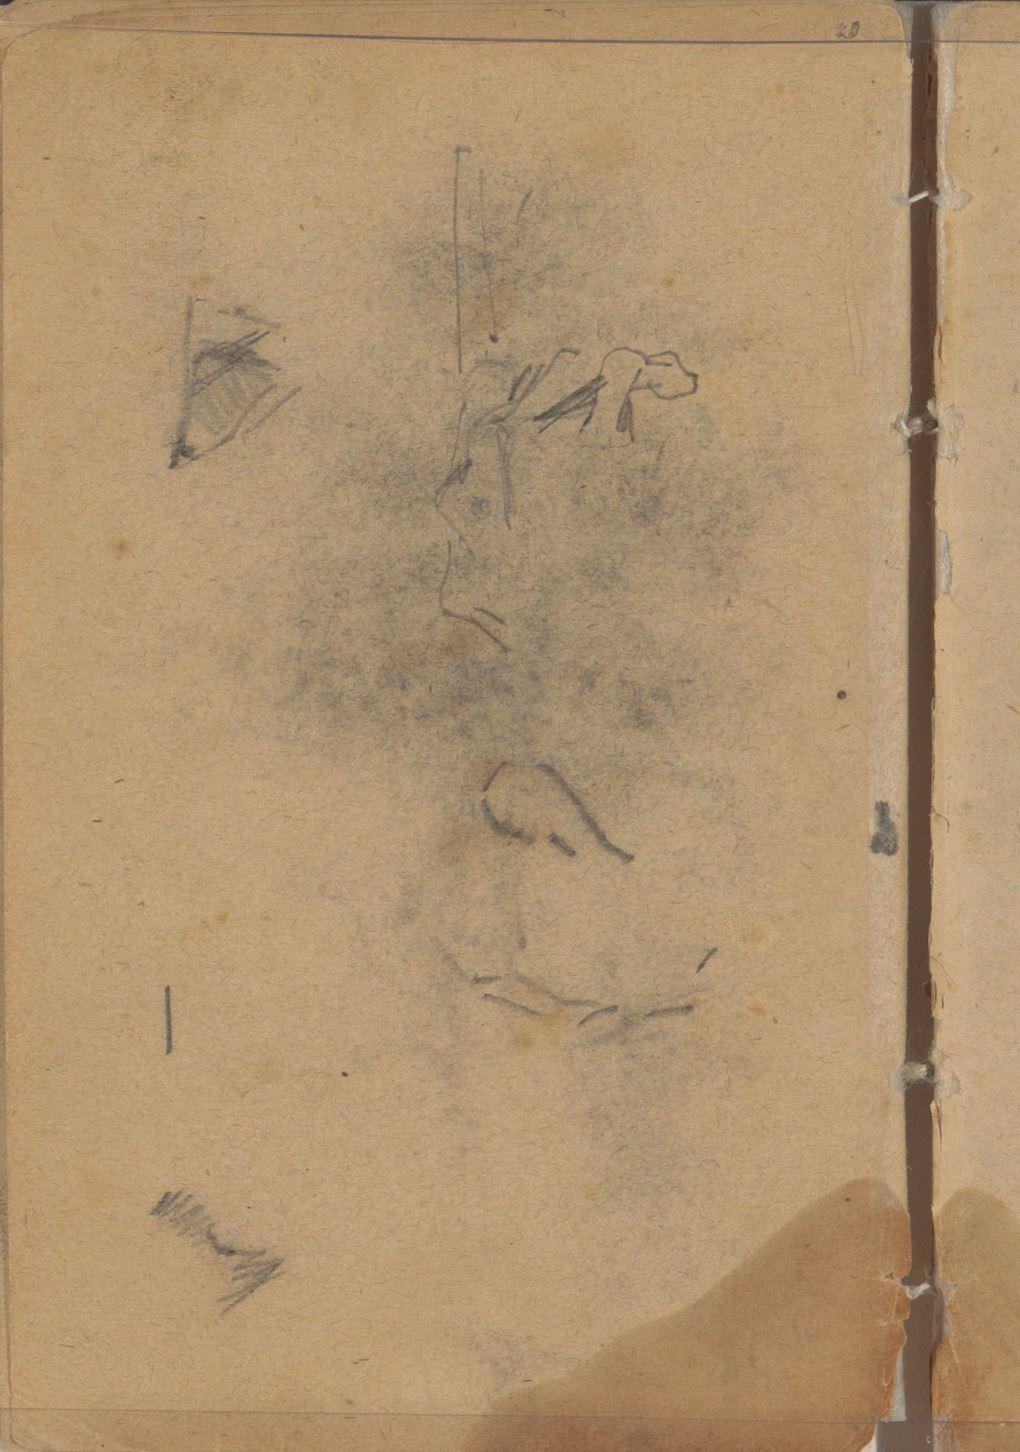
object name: sketchbook leaf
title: Studieblad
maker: george hendrik breitner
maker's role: draughtsman, painter, print maker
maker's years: 1857-1923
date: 1881-1883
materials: paper, pencil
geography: south holland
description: Studieblad. Pagina 28 uit een schetsboek met 70 bladen.